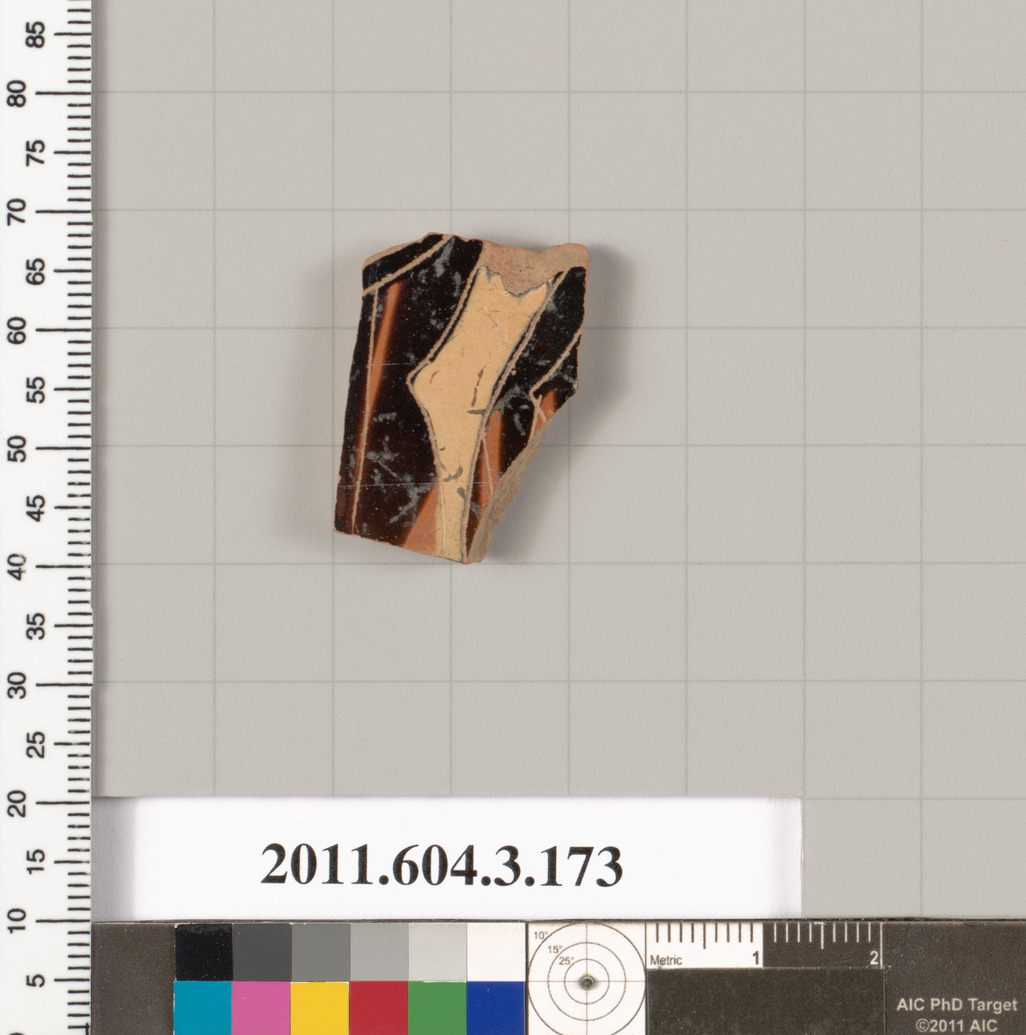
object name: amphora fragment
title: Terracotta fragment of an amphora (jar)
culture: greek, attic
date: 550-540 BCE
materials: terracotta